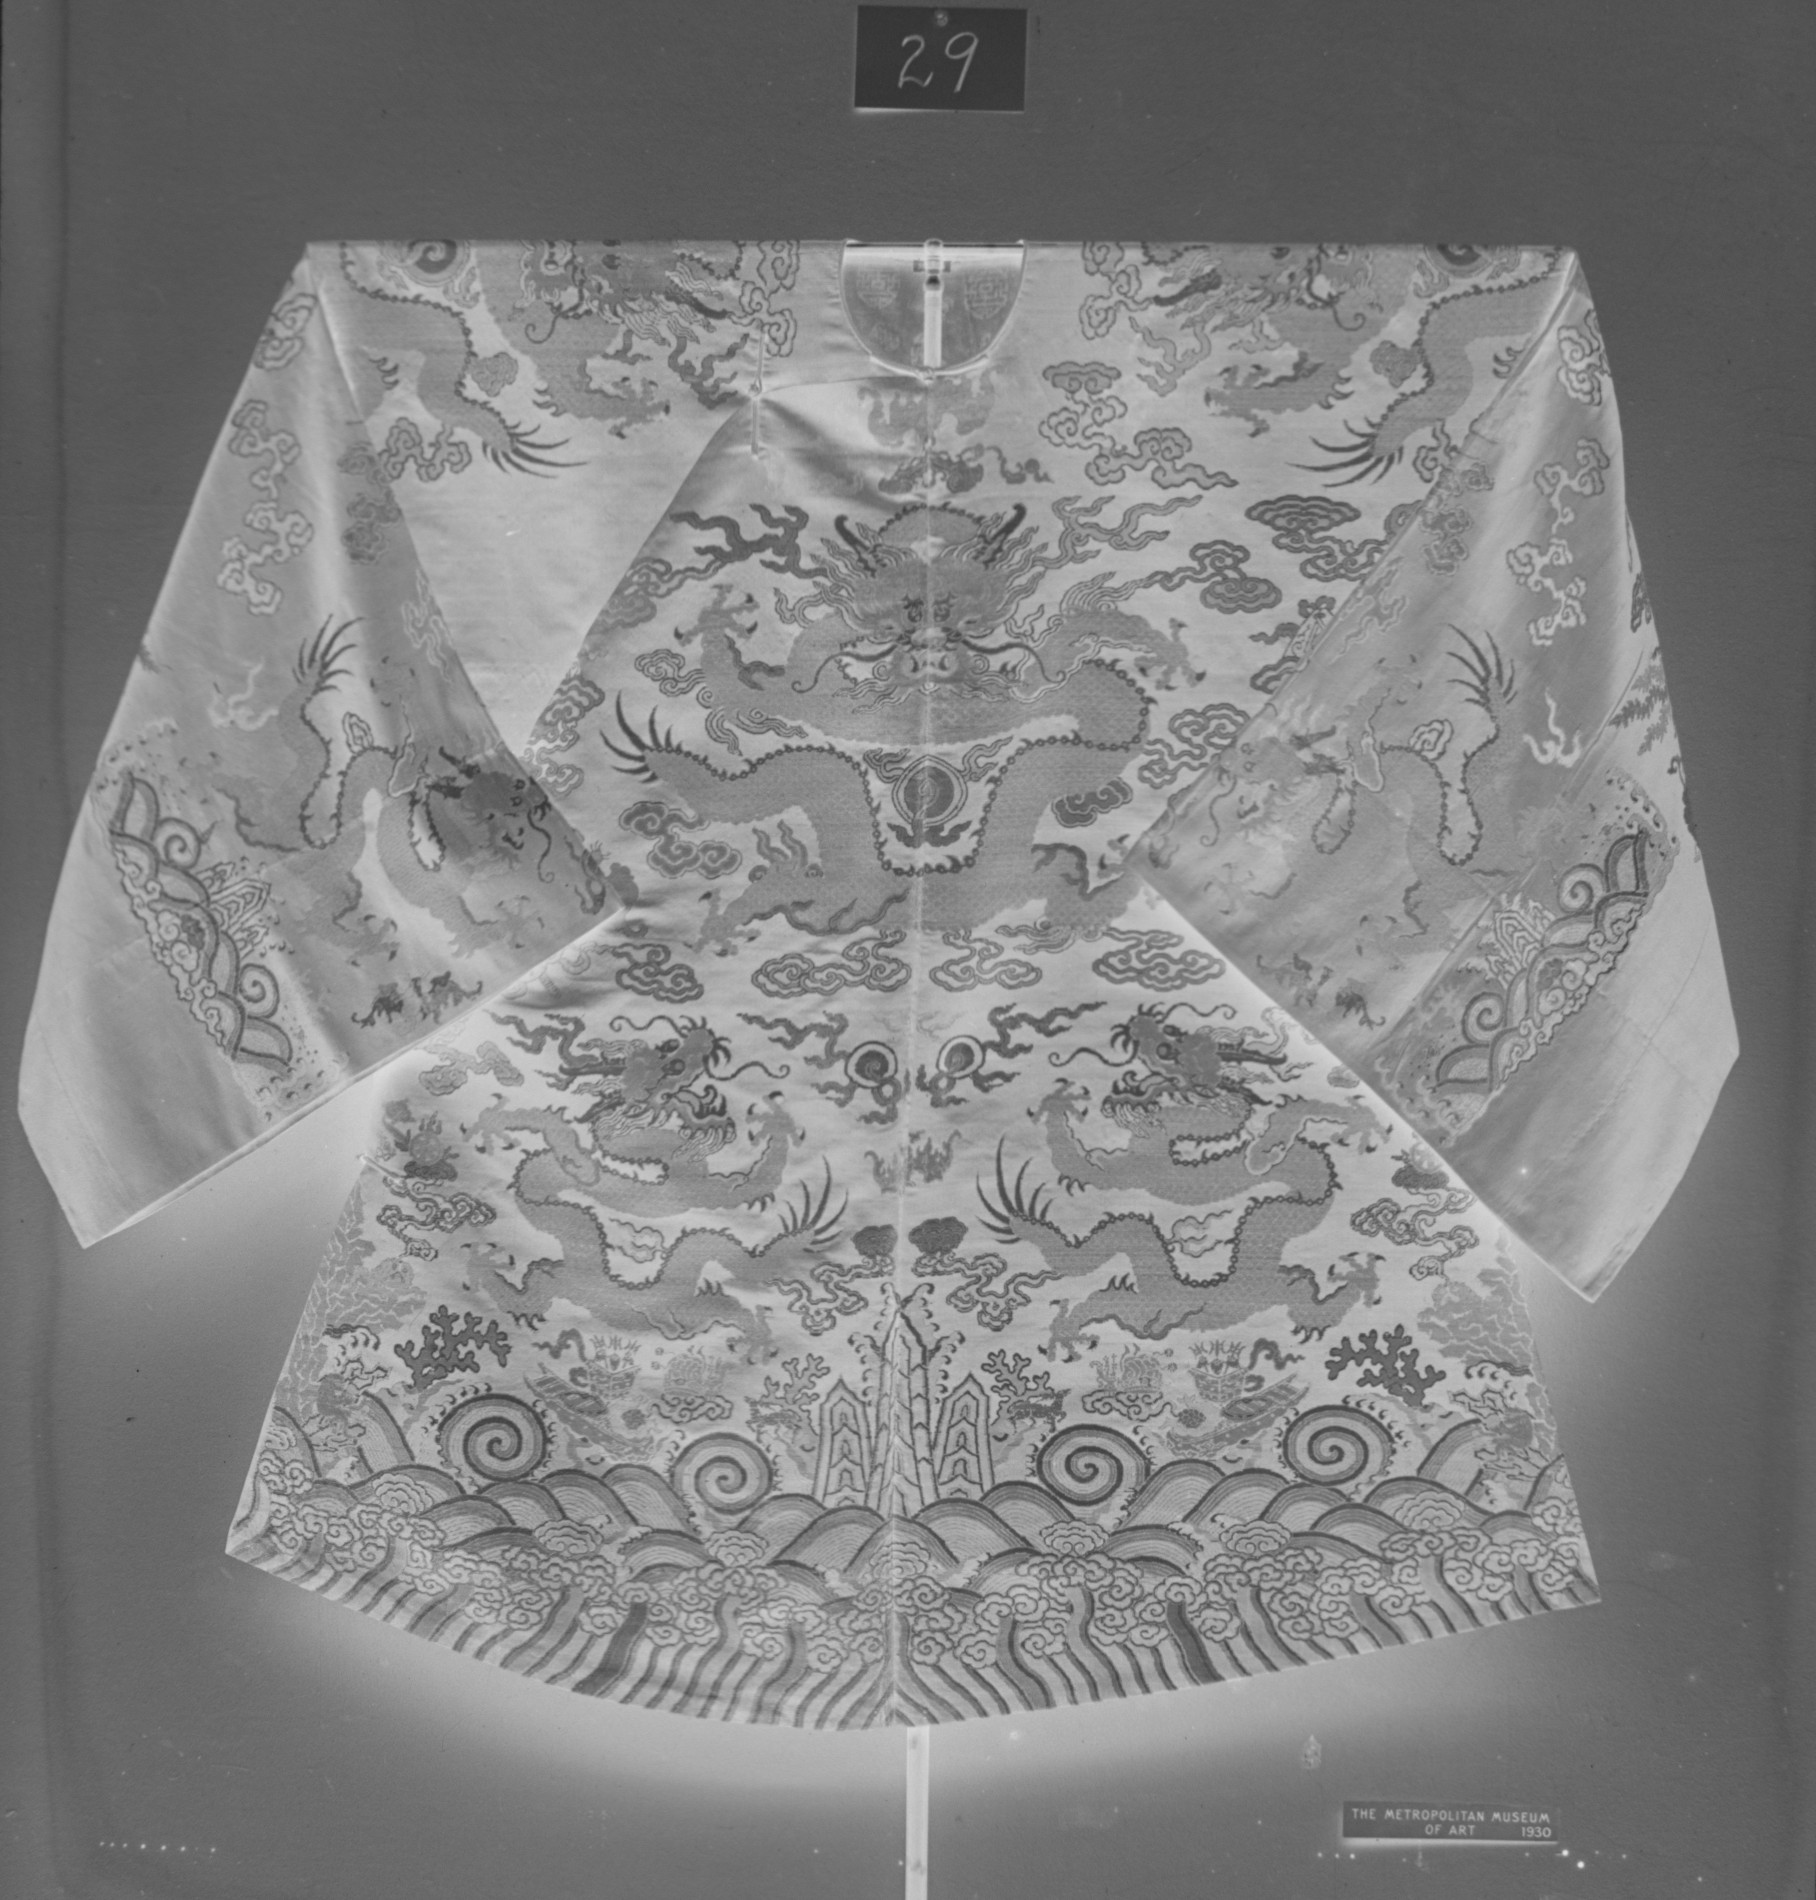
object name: coat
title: Coat with Buddhist and Taoist Symbols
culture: chinese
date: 1767-1833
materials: metal thread, silk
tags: dragons,buddhism,daoism